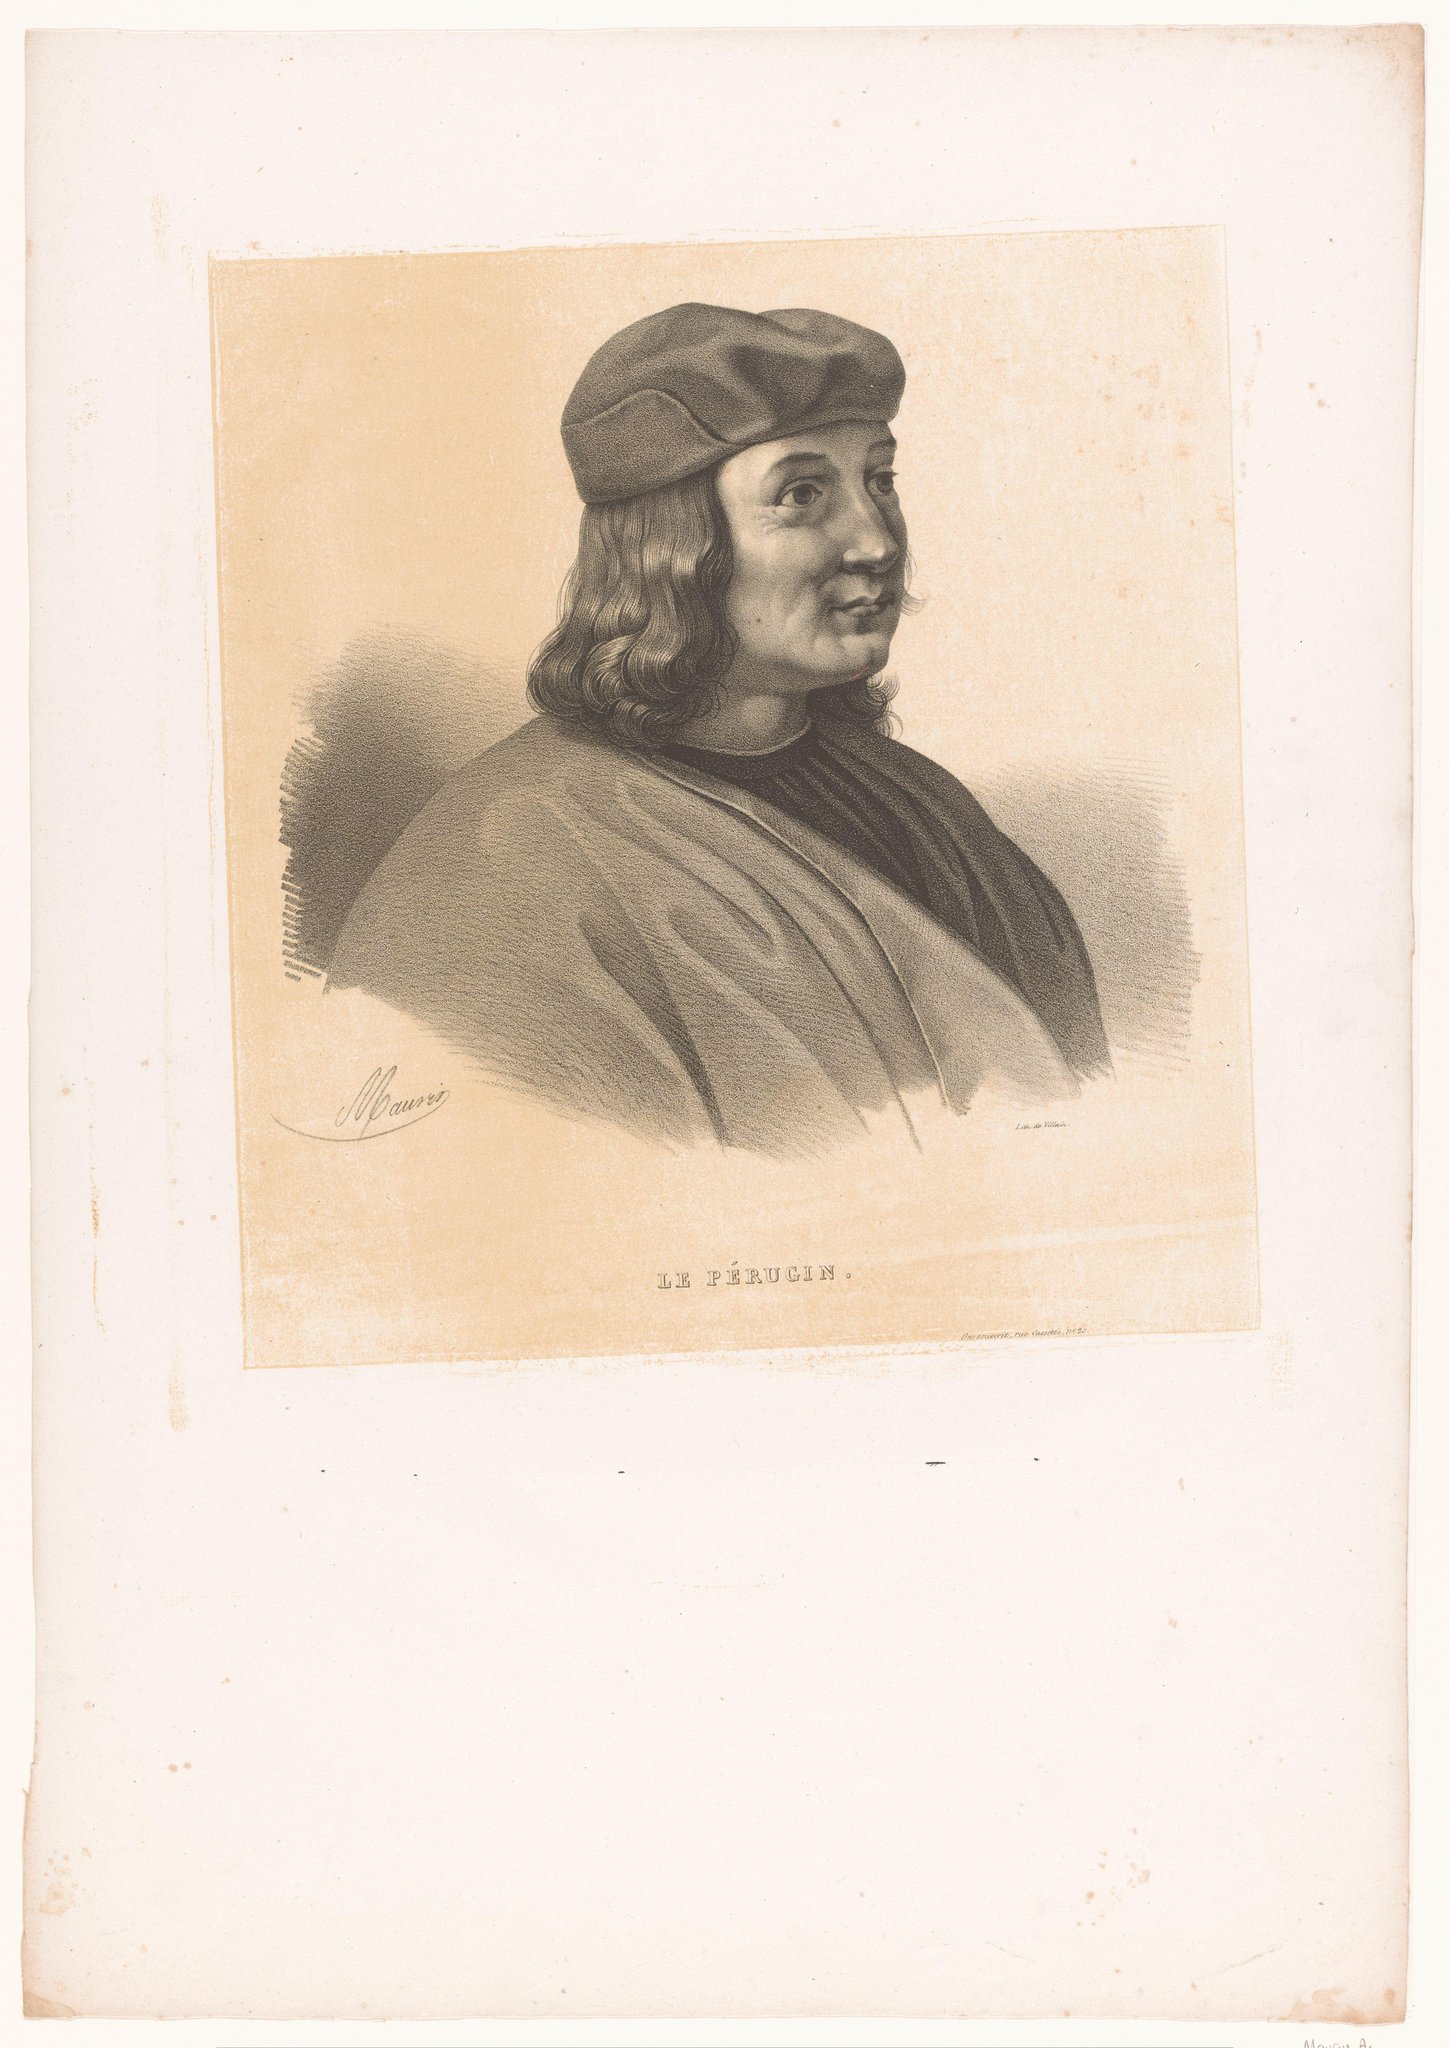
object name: print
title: Portret van Pietro Perugino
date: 1826-1852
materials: paper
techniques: tone lithography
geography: paris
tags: pietro perugino, historical persons, portrait, self-portrait of painter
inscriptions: collector's mark: Lugt 2233, check stamp: ‘JC’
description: Prent ook gebruikt in: Chabert, Jean Claude. Galerie des peintres ou collection de portraits des peintres les plus célèbres de toutes les écoles. Accompagnée d'une notice sur chacun d'eux, et de copies de dessins originaux / Galerie des peintres ou collection de portraits des peintres les plus célèbres de toutes les écoles. Accompagnée de leur notice historique, de leurs dessins et d'un discours sur les arts. Parijs: Jean Claude Chabert, s.a. [1822-1834]. De samenstelling van tegenwoordig bekende en al dan niet gebonden exemplaren van deze uitgave verschillen. Dit omdat de prenten en bijhorende stukken tekst op inschrijving en waarschijnlijk ook los verkrijgbaar waren.